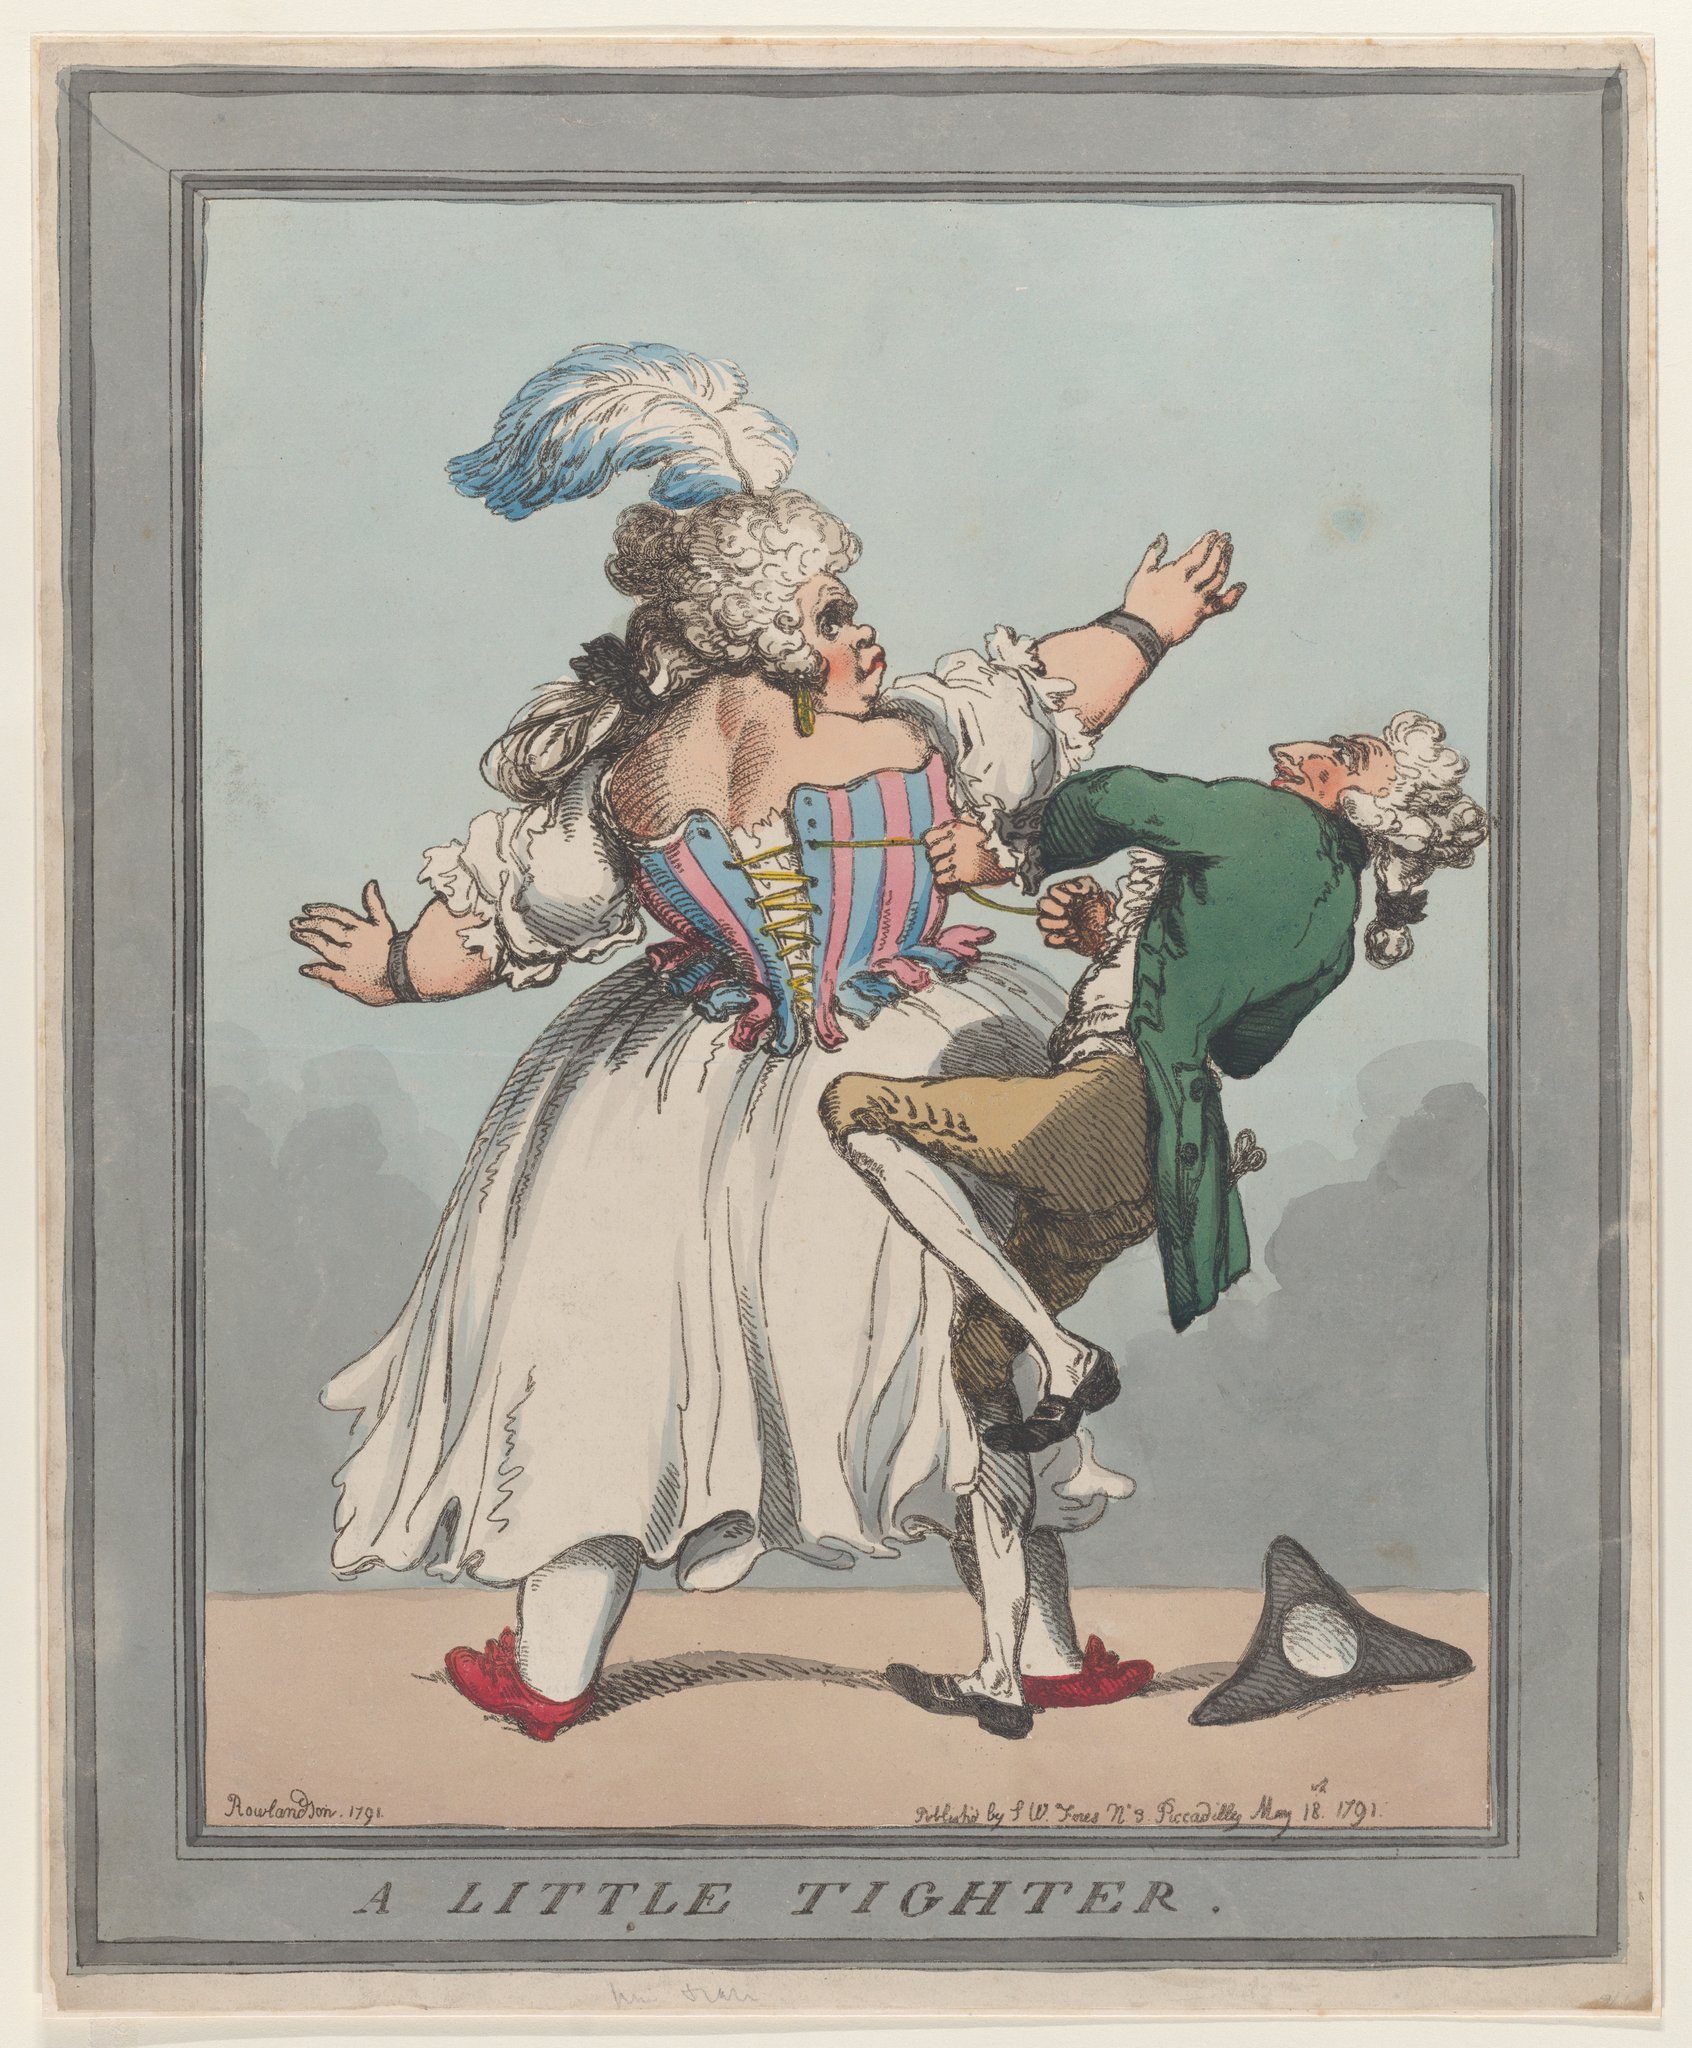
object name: print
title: A Little Tighter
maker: thomas rowlandson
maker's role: artist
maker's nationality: british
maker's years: 1757-1827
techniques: etching